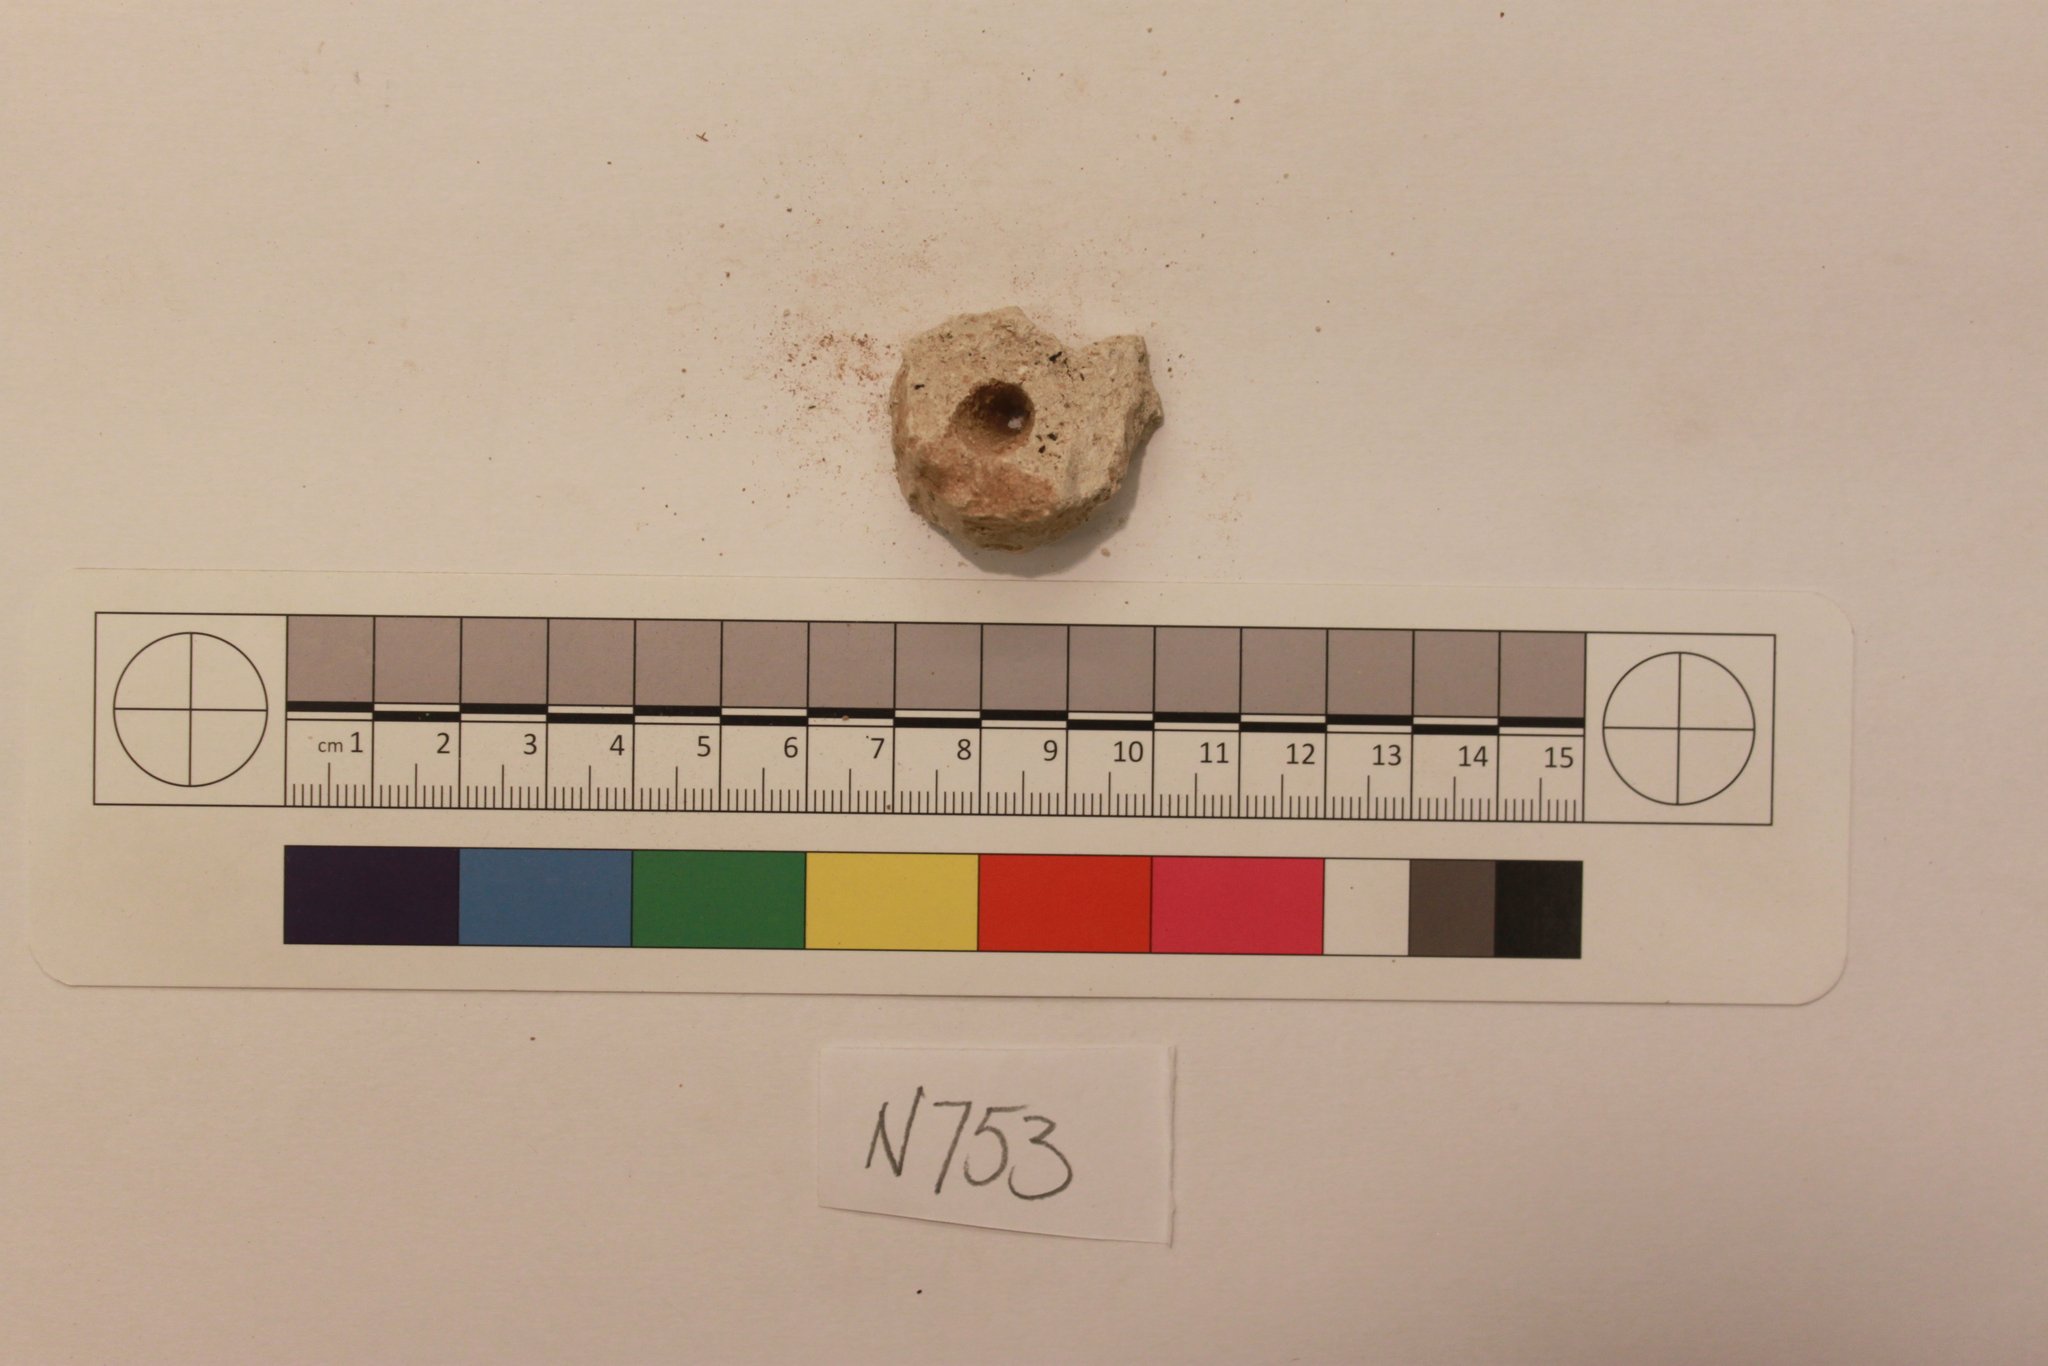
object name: fragment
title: Stucco Fragment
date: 701-1200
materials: plaster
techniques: carving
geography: iran